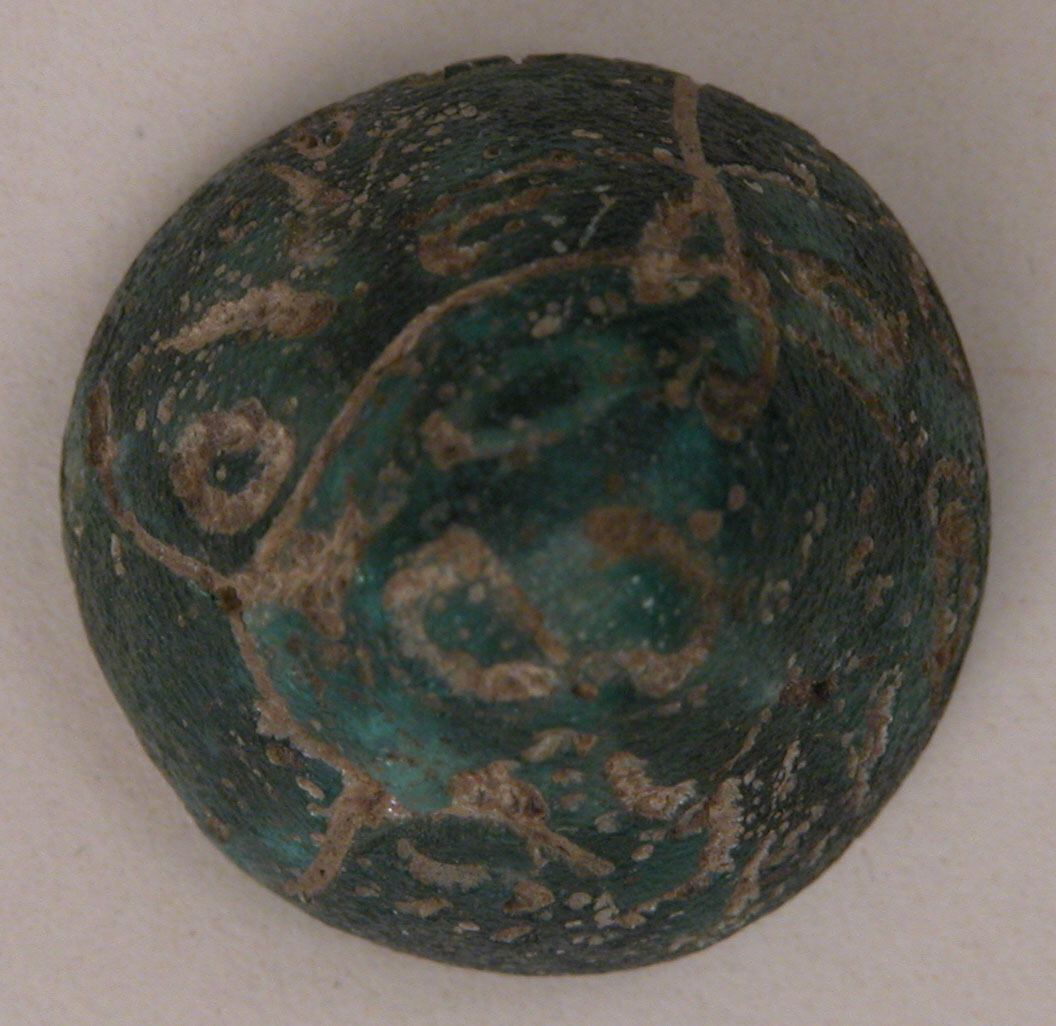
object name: gaming piece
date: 701-1200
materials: glass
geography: islamic lands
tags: games